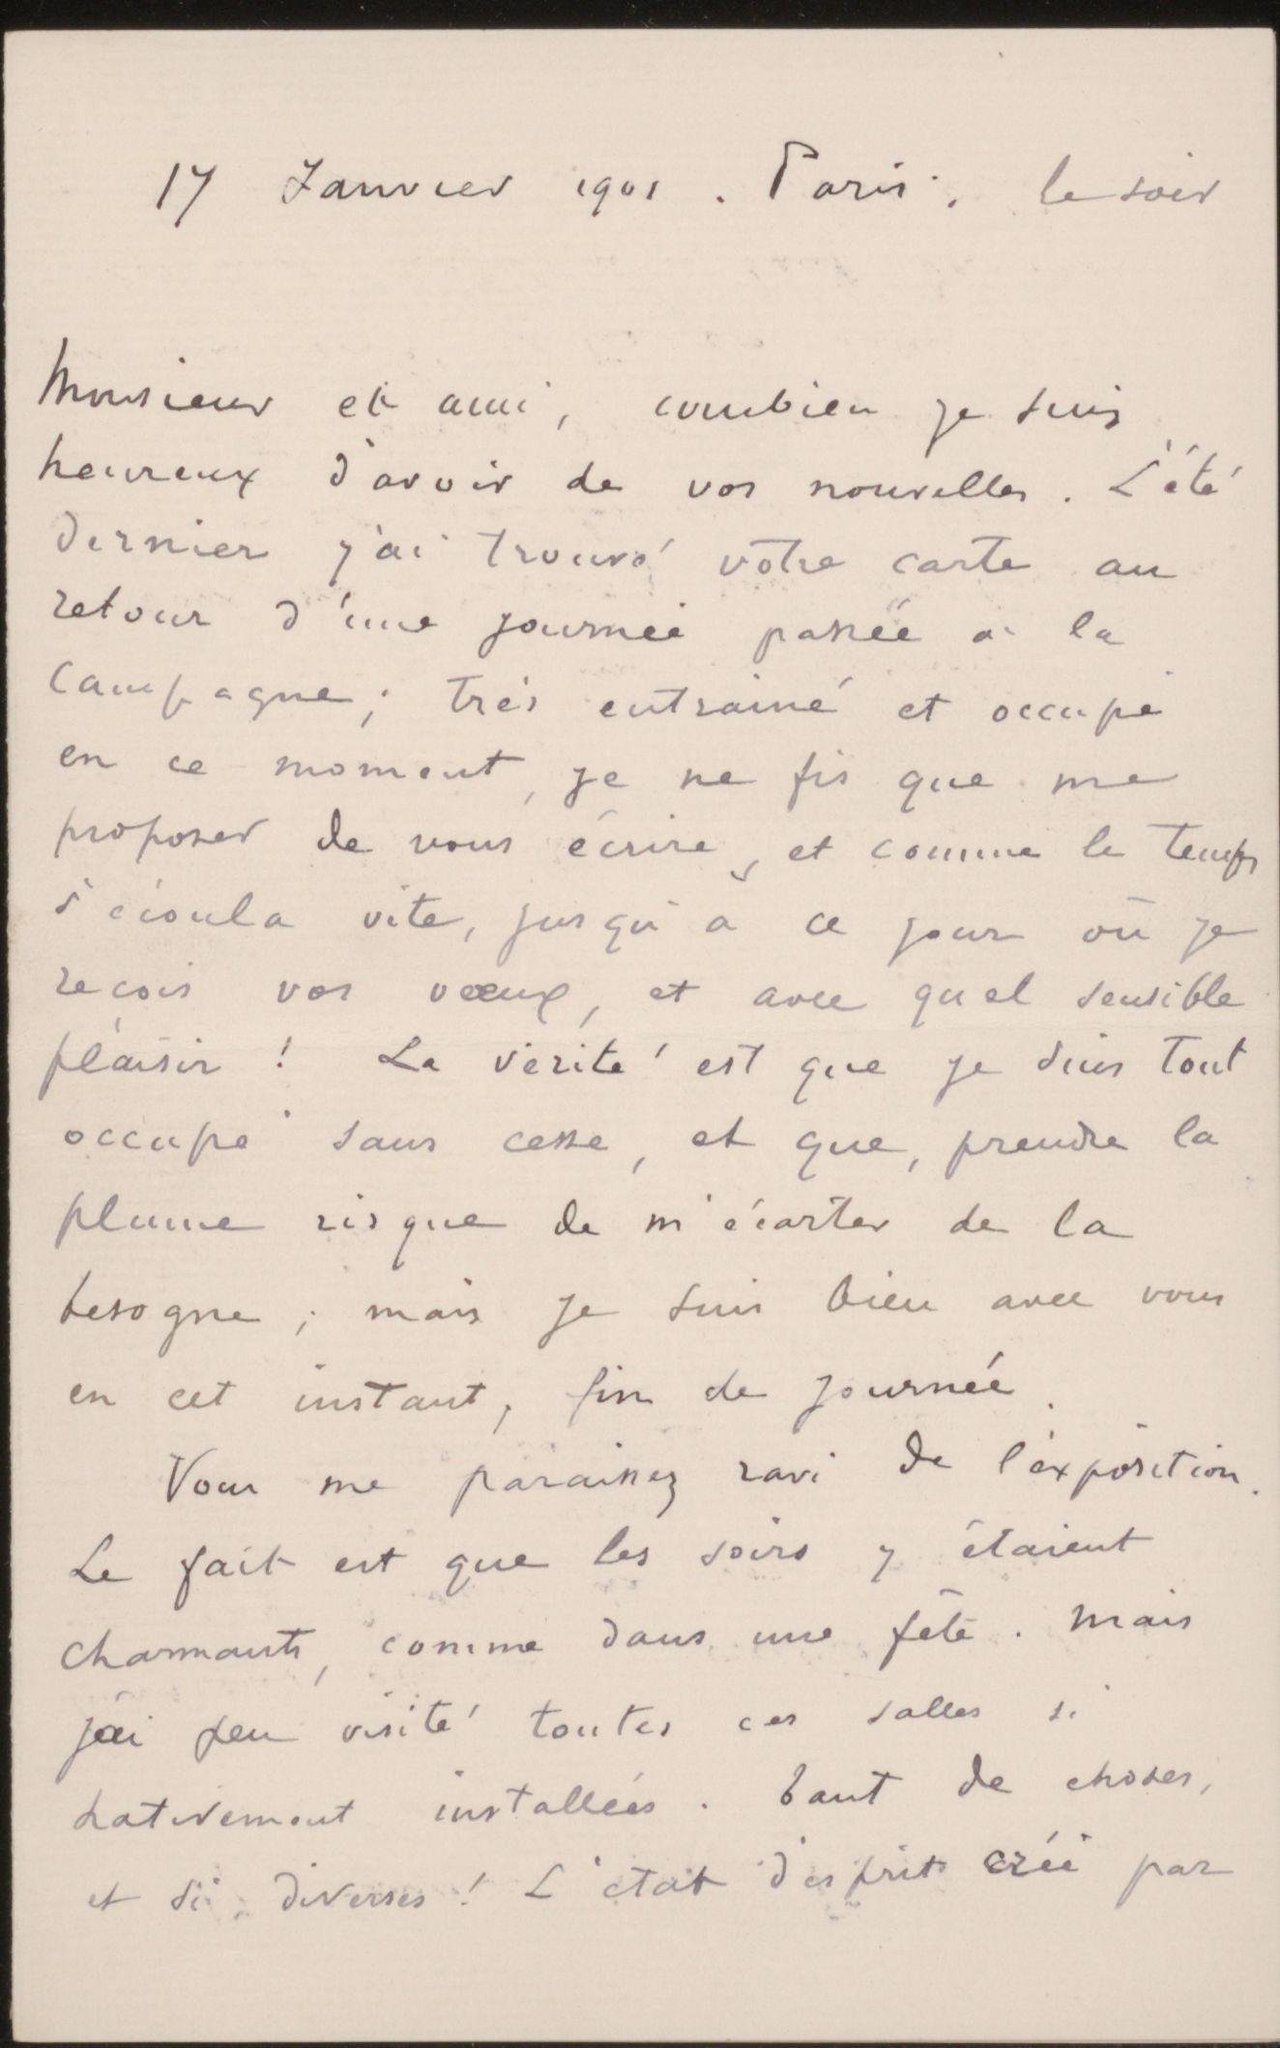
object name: letter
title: Brief aan Andries Bonger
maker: odilon redon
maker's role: draughtsman, painter, print maker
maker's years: 1840-1916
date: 1901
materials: ink, paper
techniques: pen, writing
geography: paris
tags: camille redon-falte, arï redon, lille, print maker, émile bernard, painter, draughtsman, vincent van gogh, paul gauguin, amsterdam, andries bonger, applied arts, arts and crafts; industrial design, family life, painting (including book-illumination, miniature-painting), exhibition ~ art, diseases, london, paris, marseille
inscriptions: watermark